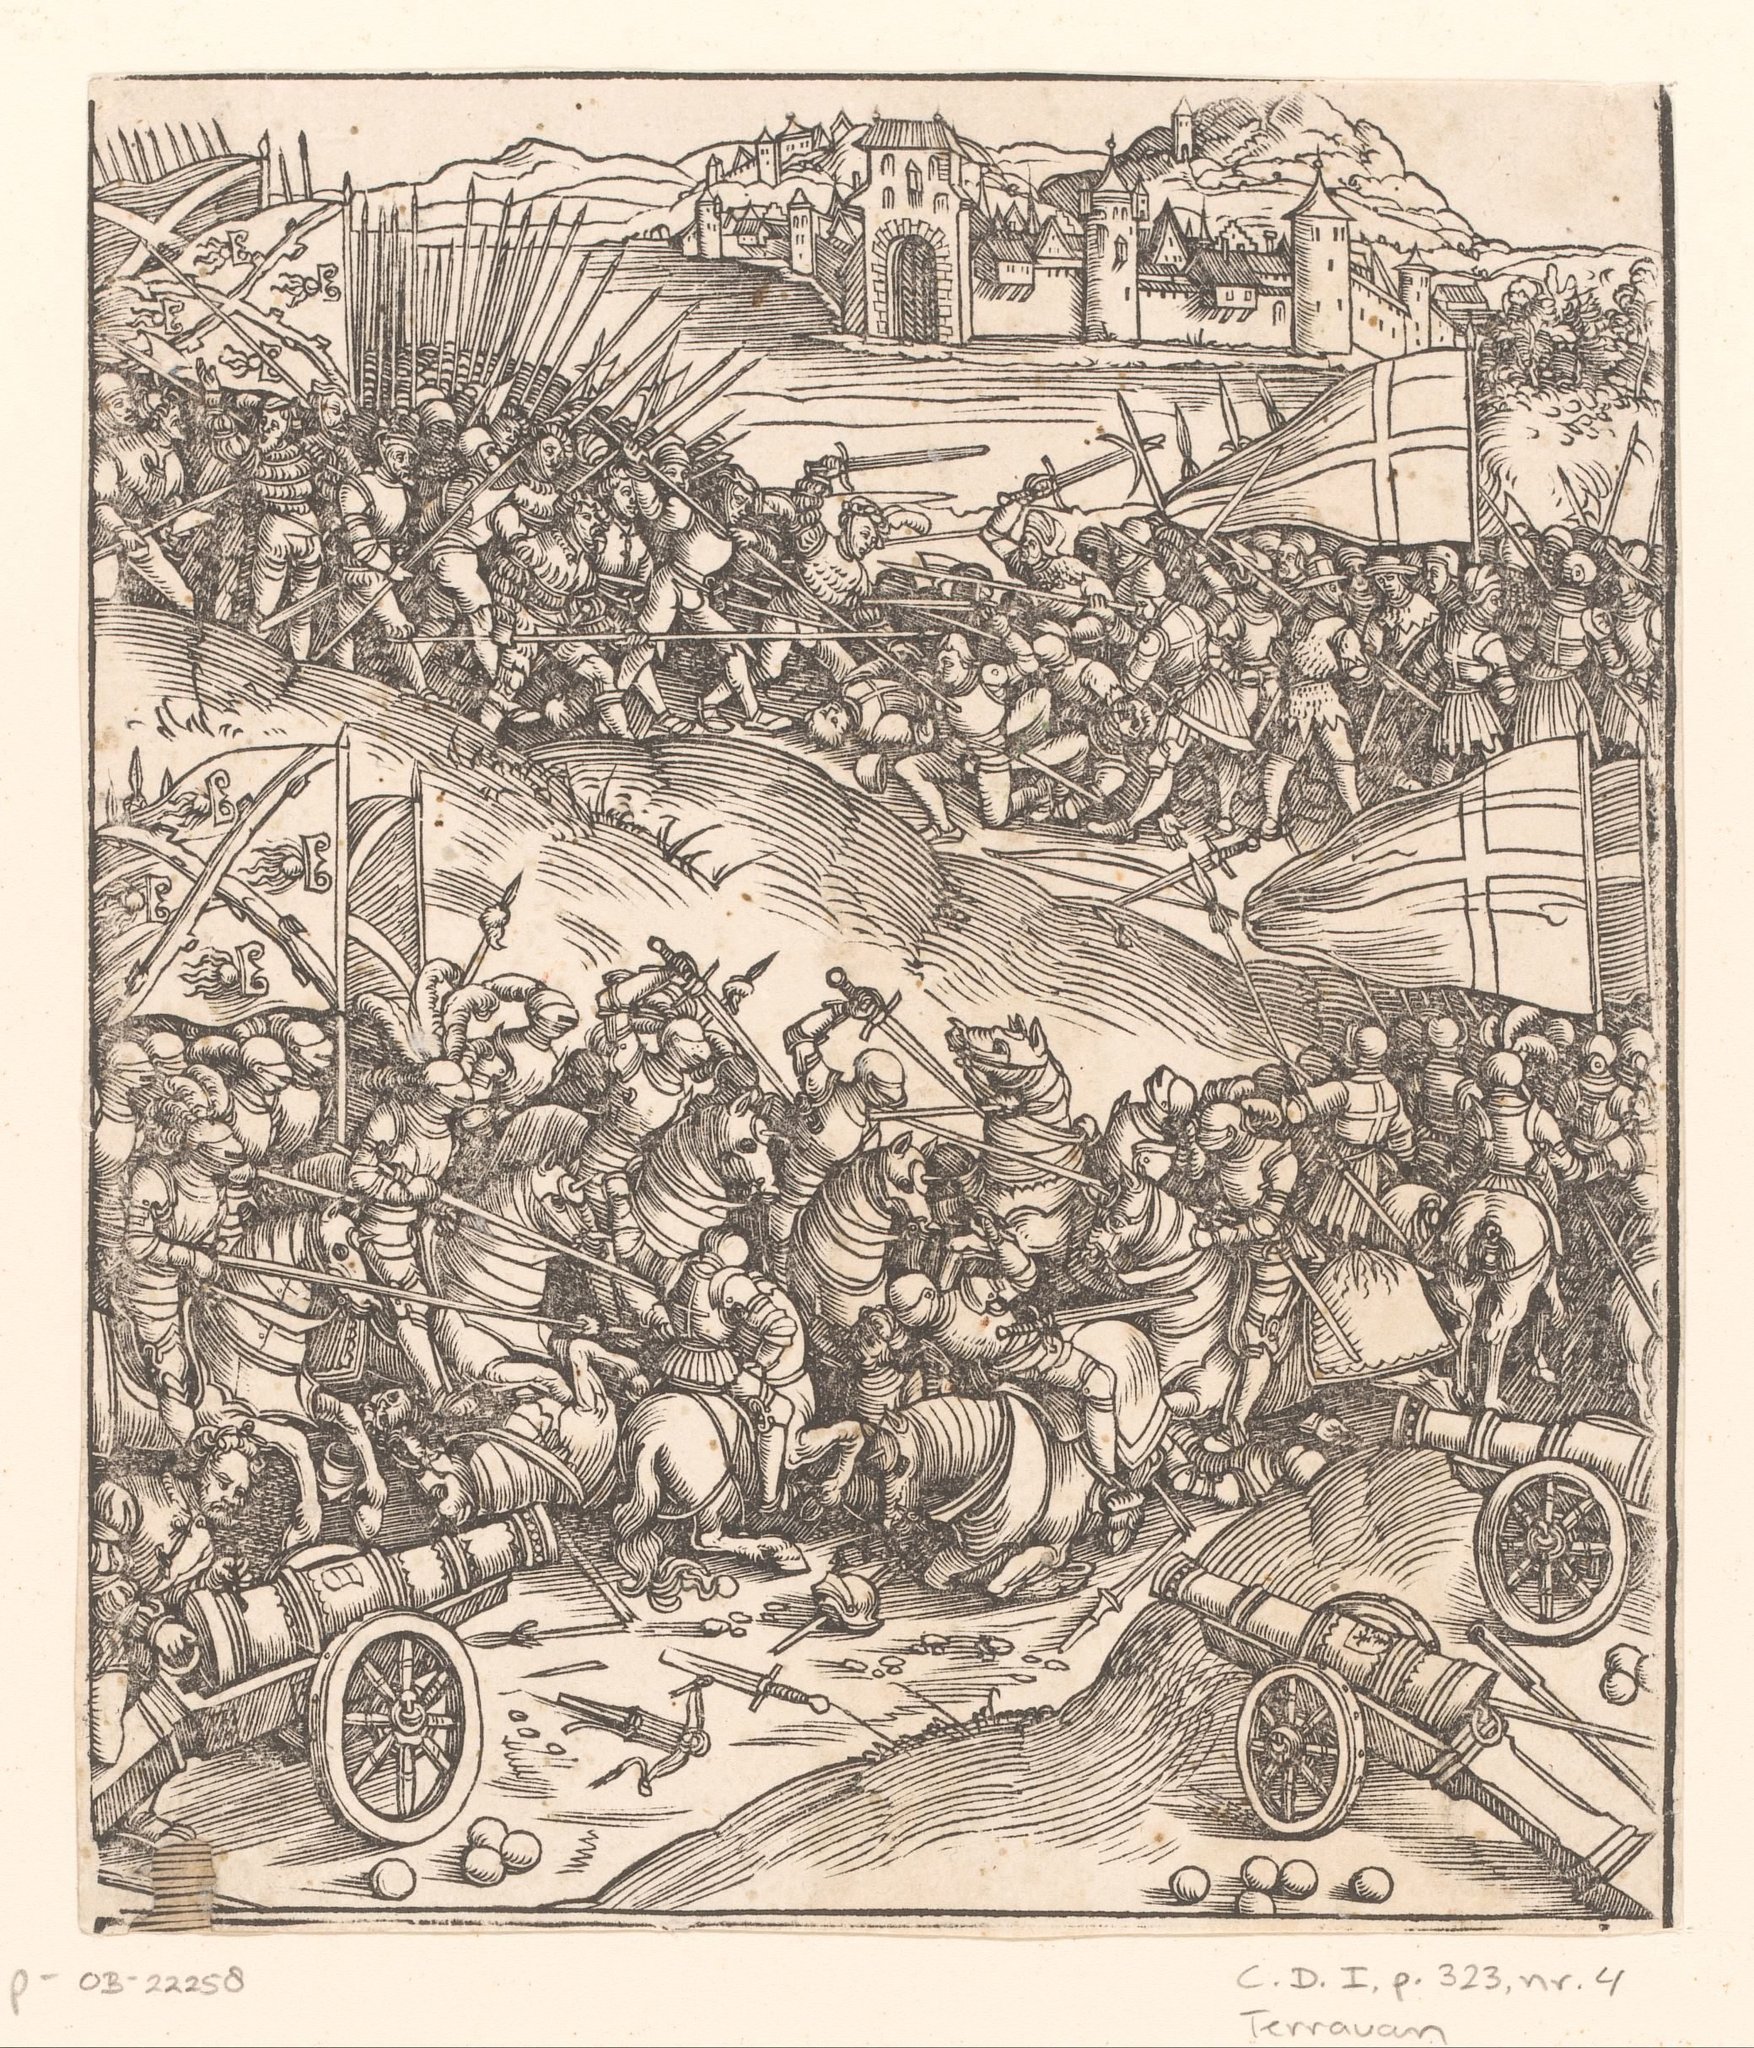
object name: print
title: Historische voorstellingen op de triomfboog van keizer Maximiliaan I, keizer van het Heilige Roomse Rijk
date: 1515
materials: paper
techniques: woodcut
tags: maximilian i (holy roman emperor), siege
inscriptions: collector's mark: Lugt 240